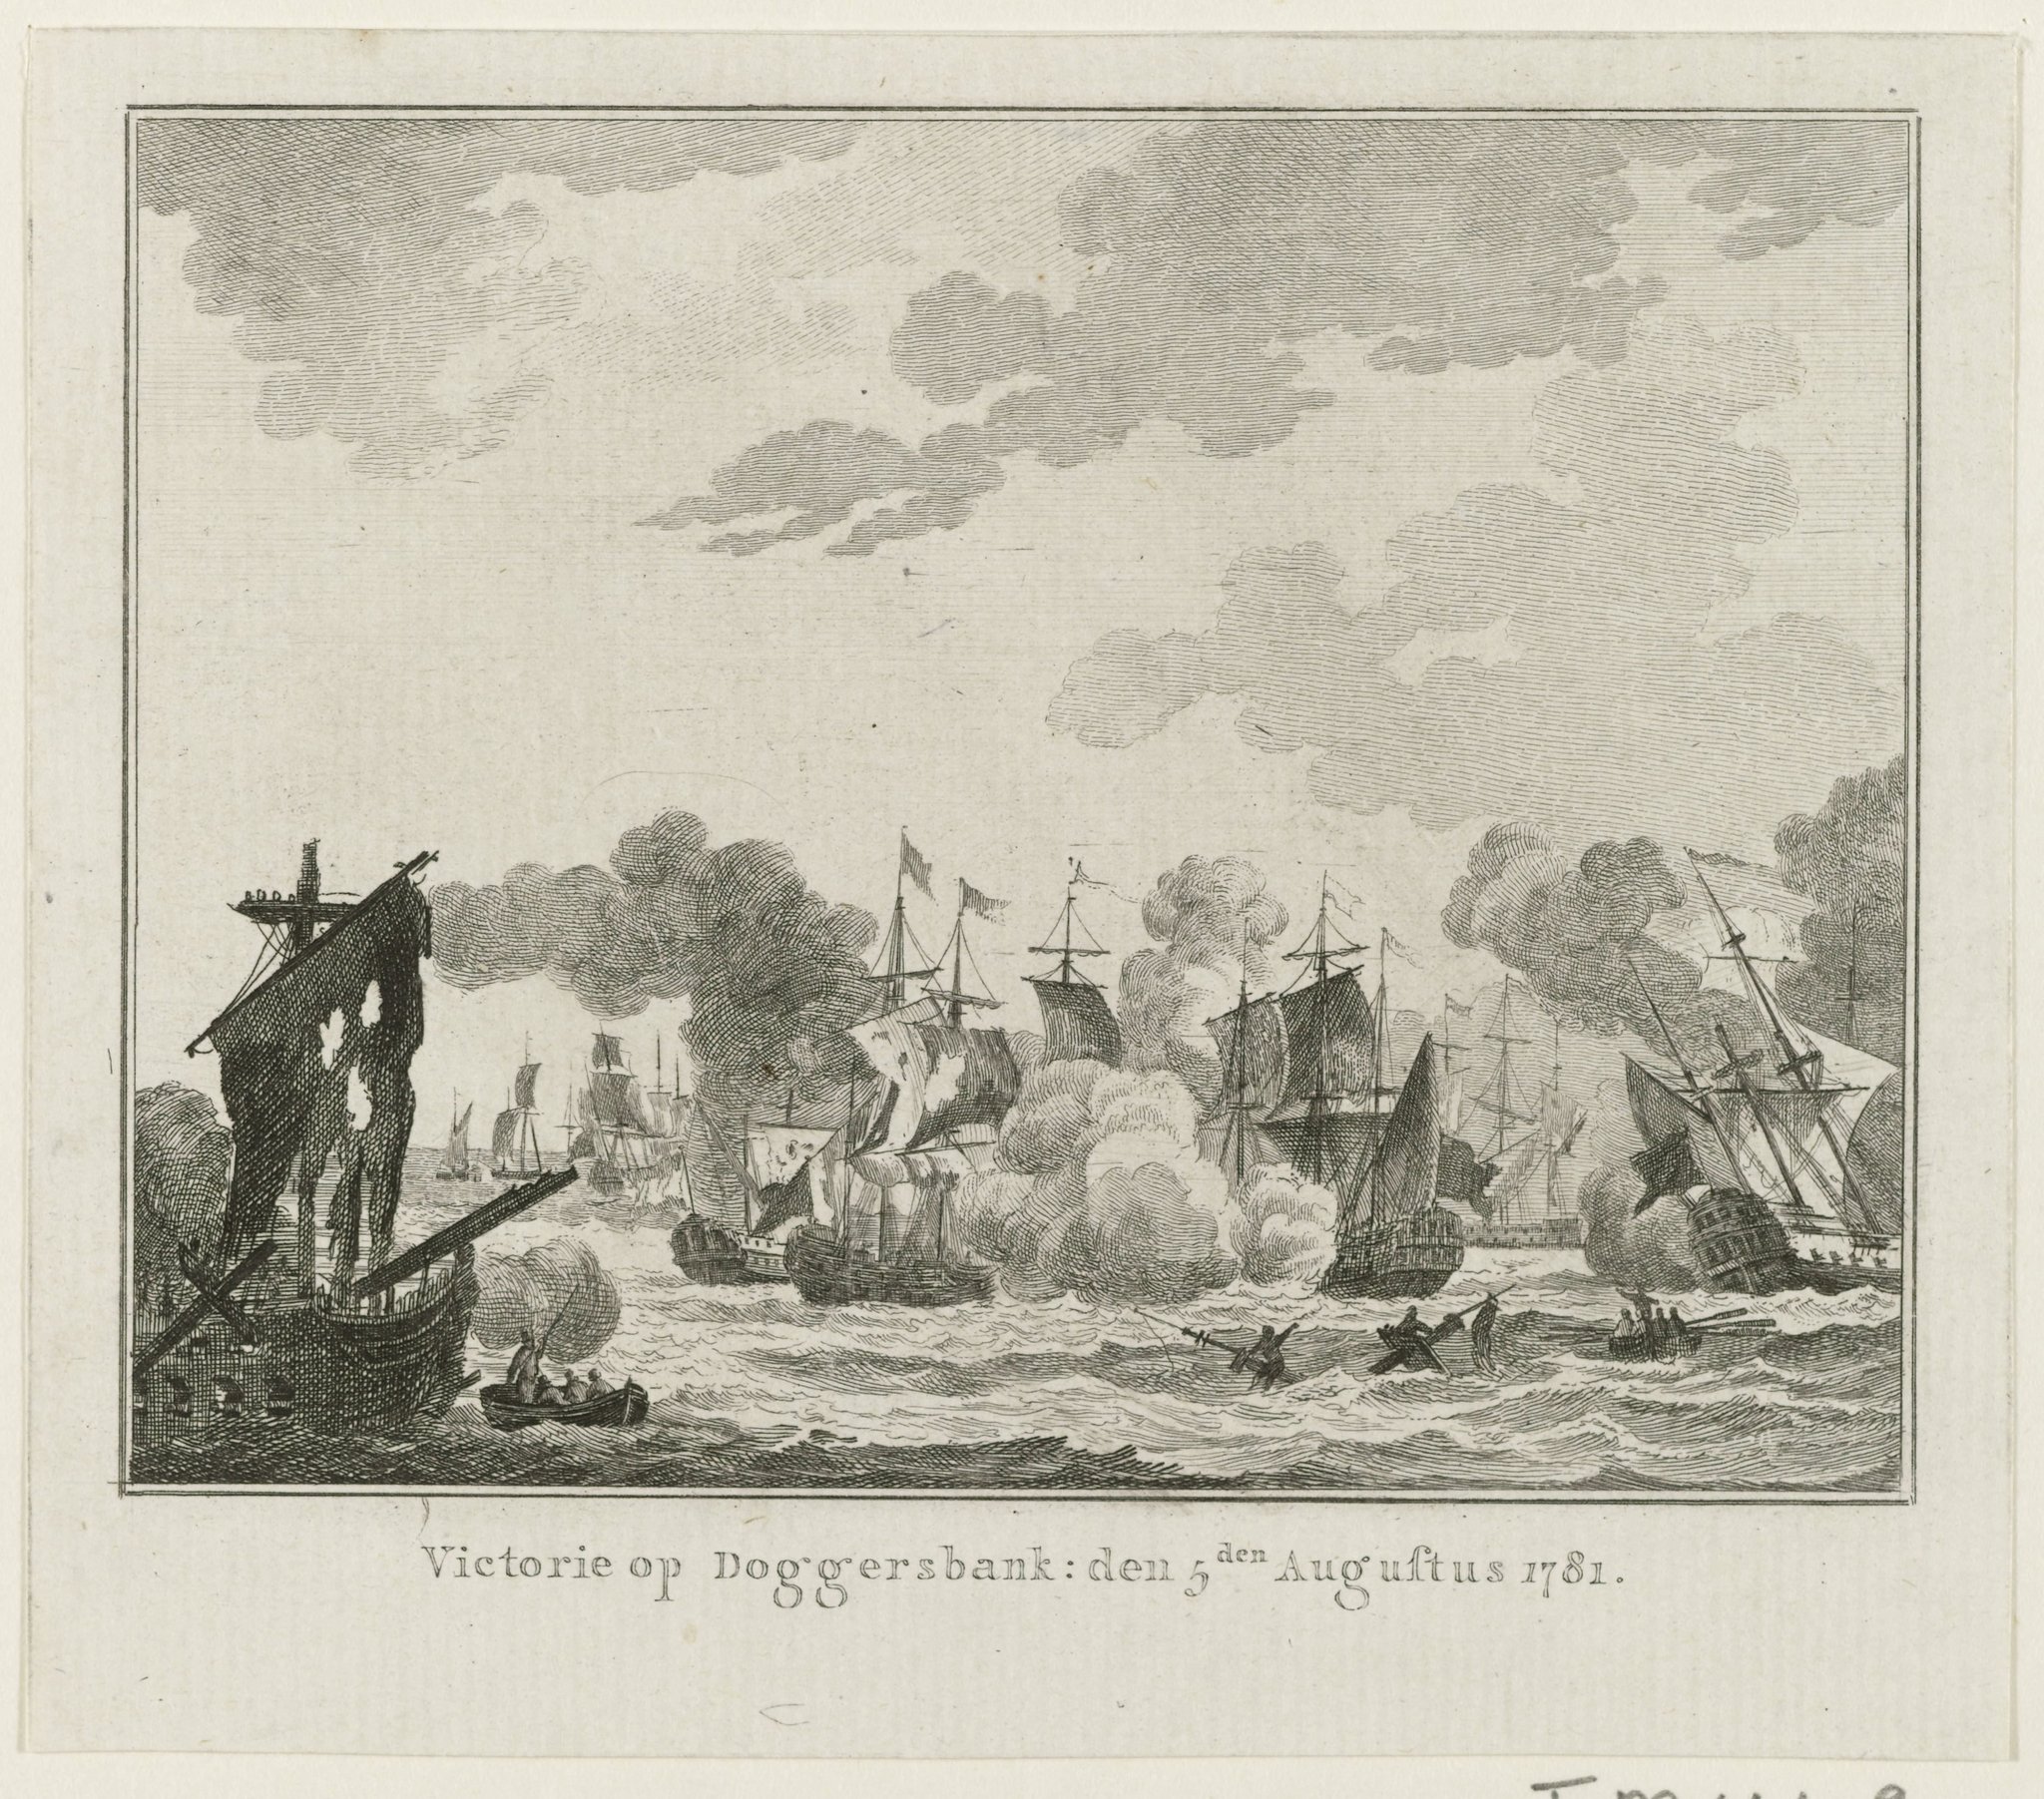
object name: print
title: Zeeslag bij Doggersbank, 1781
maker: mathias de sallieth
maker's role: print maker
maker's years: 1749-1791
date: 1781-1783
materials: paper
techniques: engraving, etching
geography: northern netherlands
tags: the hague, johan arnold zoutman, hyde parker, battle (+ naval force)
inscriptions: collector's mark: Lugt 2228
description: De Nederlandse en Engelse schepen tijdens de zeeslag bij Doggersbank op 5 augustus 1781 tussen de Nederlandse vloot onder schout-bij-nacht Johan Zoutman en de Engelse vloot onder vice-admiraal Hyde Parker.